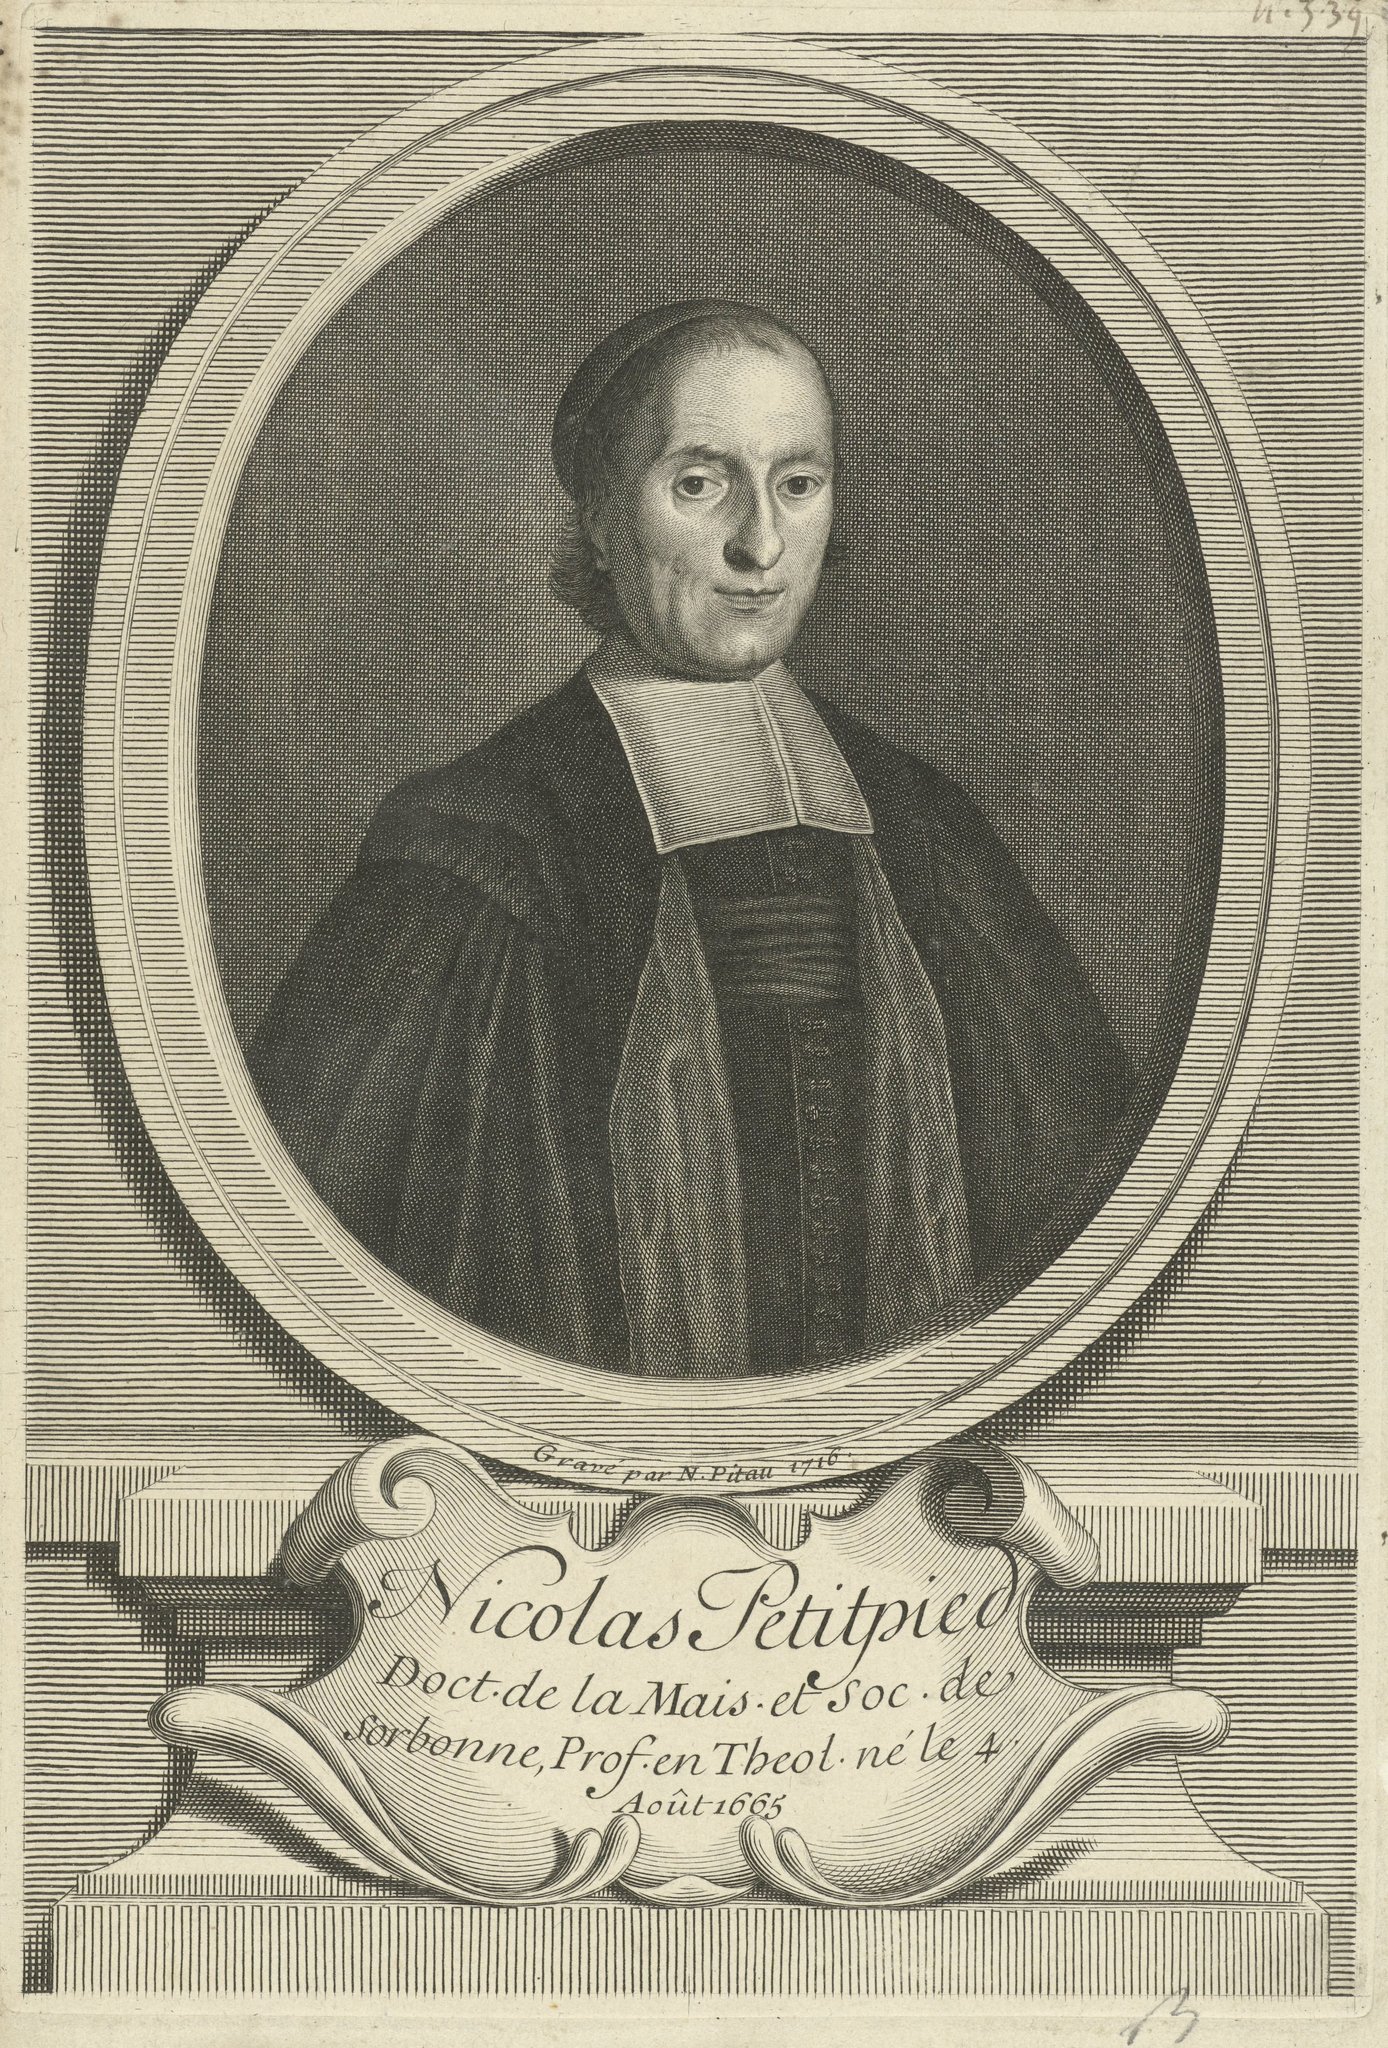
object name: print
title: Portret van de theoloog Nicolas Petitpied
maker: nicolas pitau (ii)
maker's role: print maker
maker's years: 1670-1724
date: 1716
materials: paper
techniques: engraving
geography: paris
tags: paris, liturgical vestments, canonicals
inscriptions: inscription, number: ‘n. 339’, collector's mark: Lugt 2228